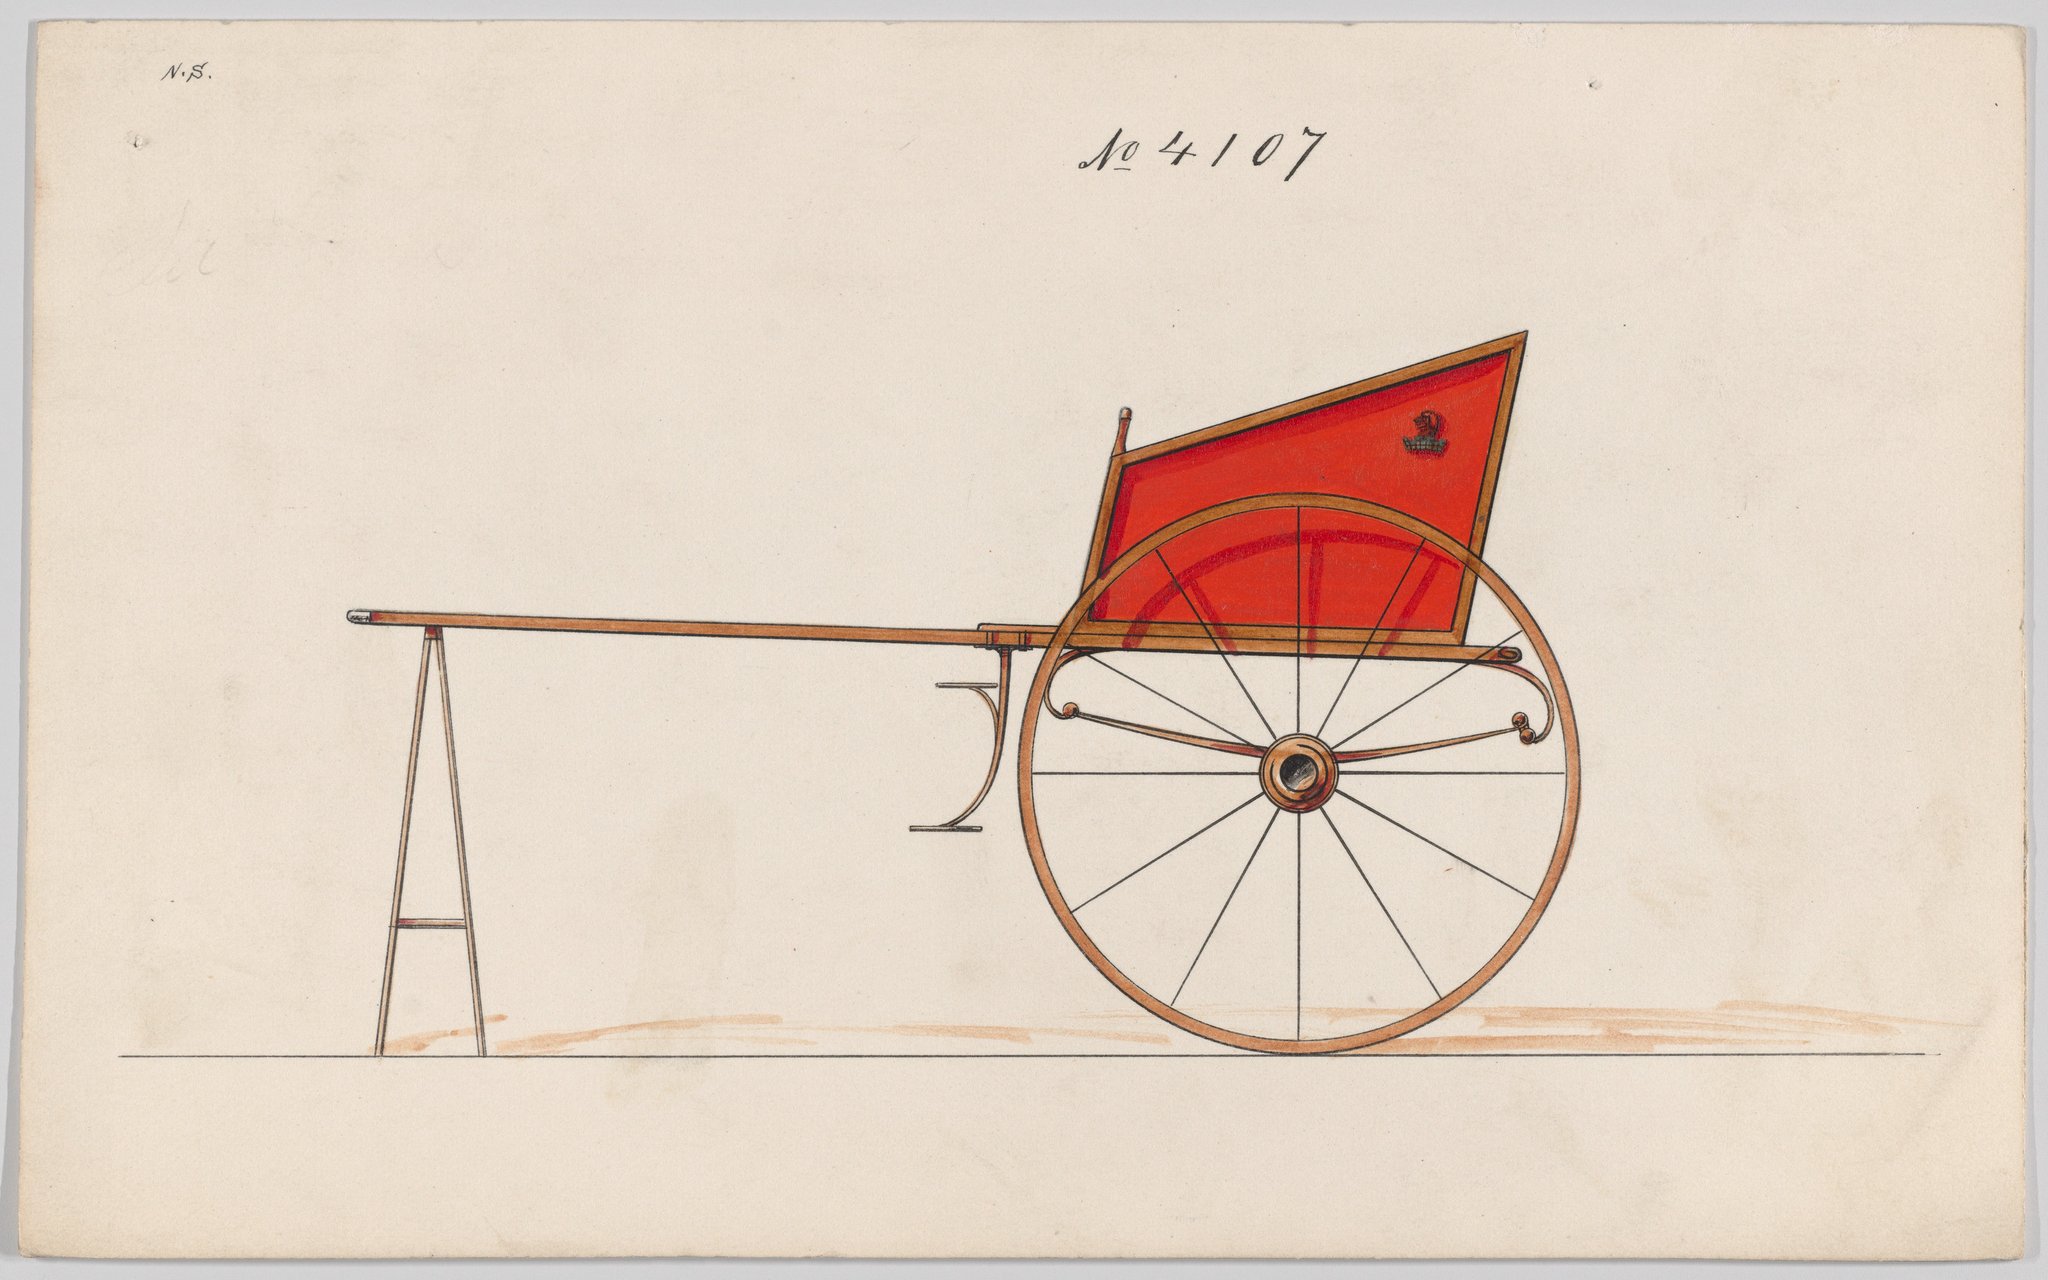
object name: drawing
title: Mail Cart #4107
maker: brewster & co.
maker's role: manufacturer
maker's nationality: american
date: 1890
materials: gouache, gum arabic, ink, watercolor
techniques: pen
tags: carriages